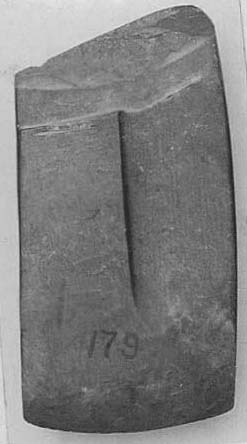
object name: hatchet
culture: swiss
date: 1902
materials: jade